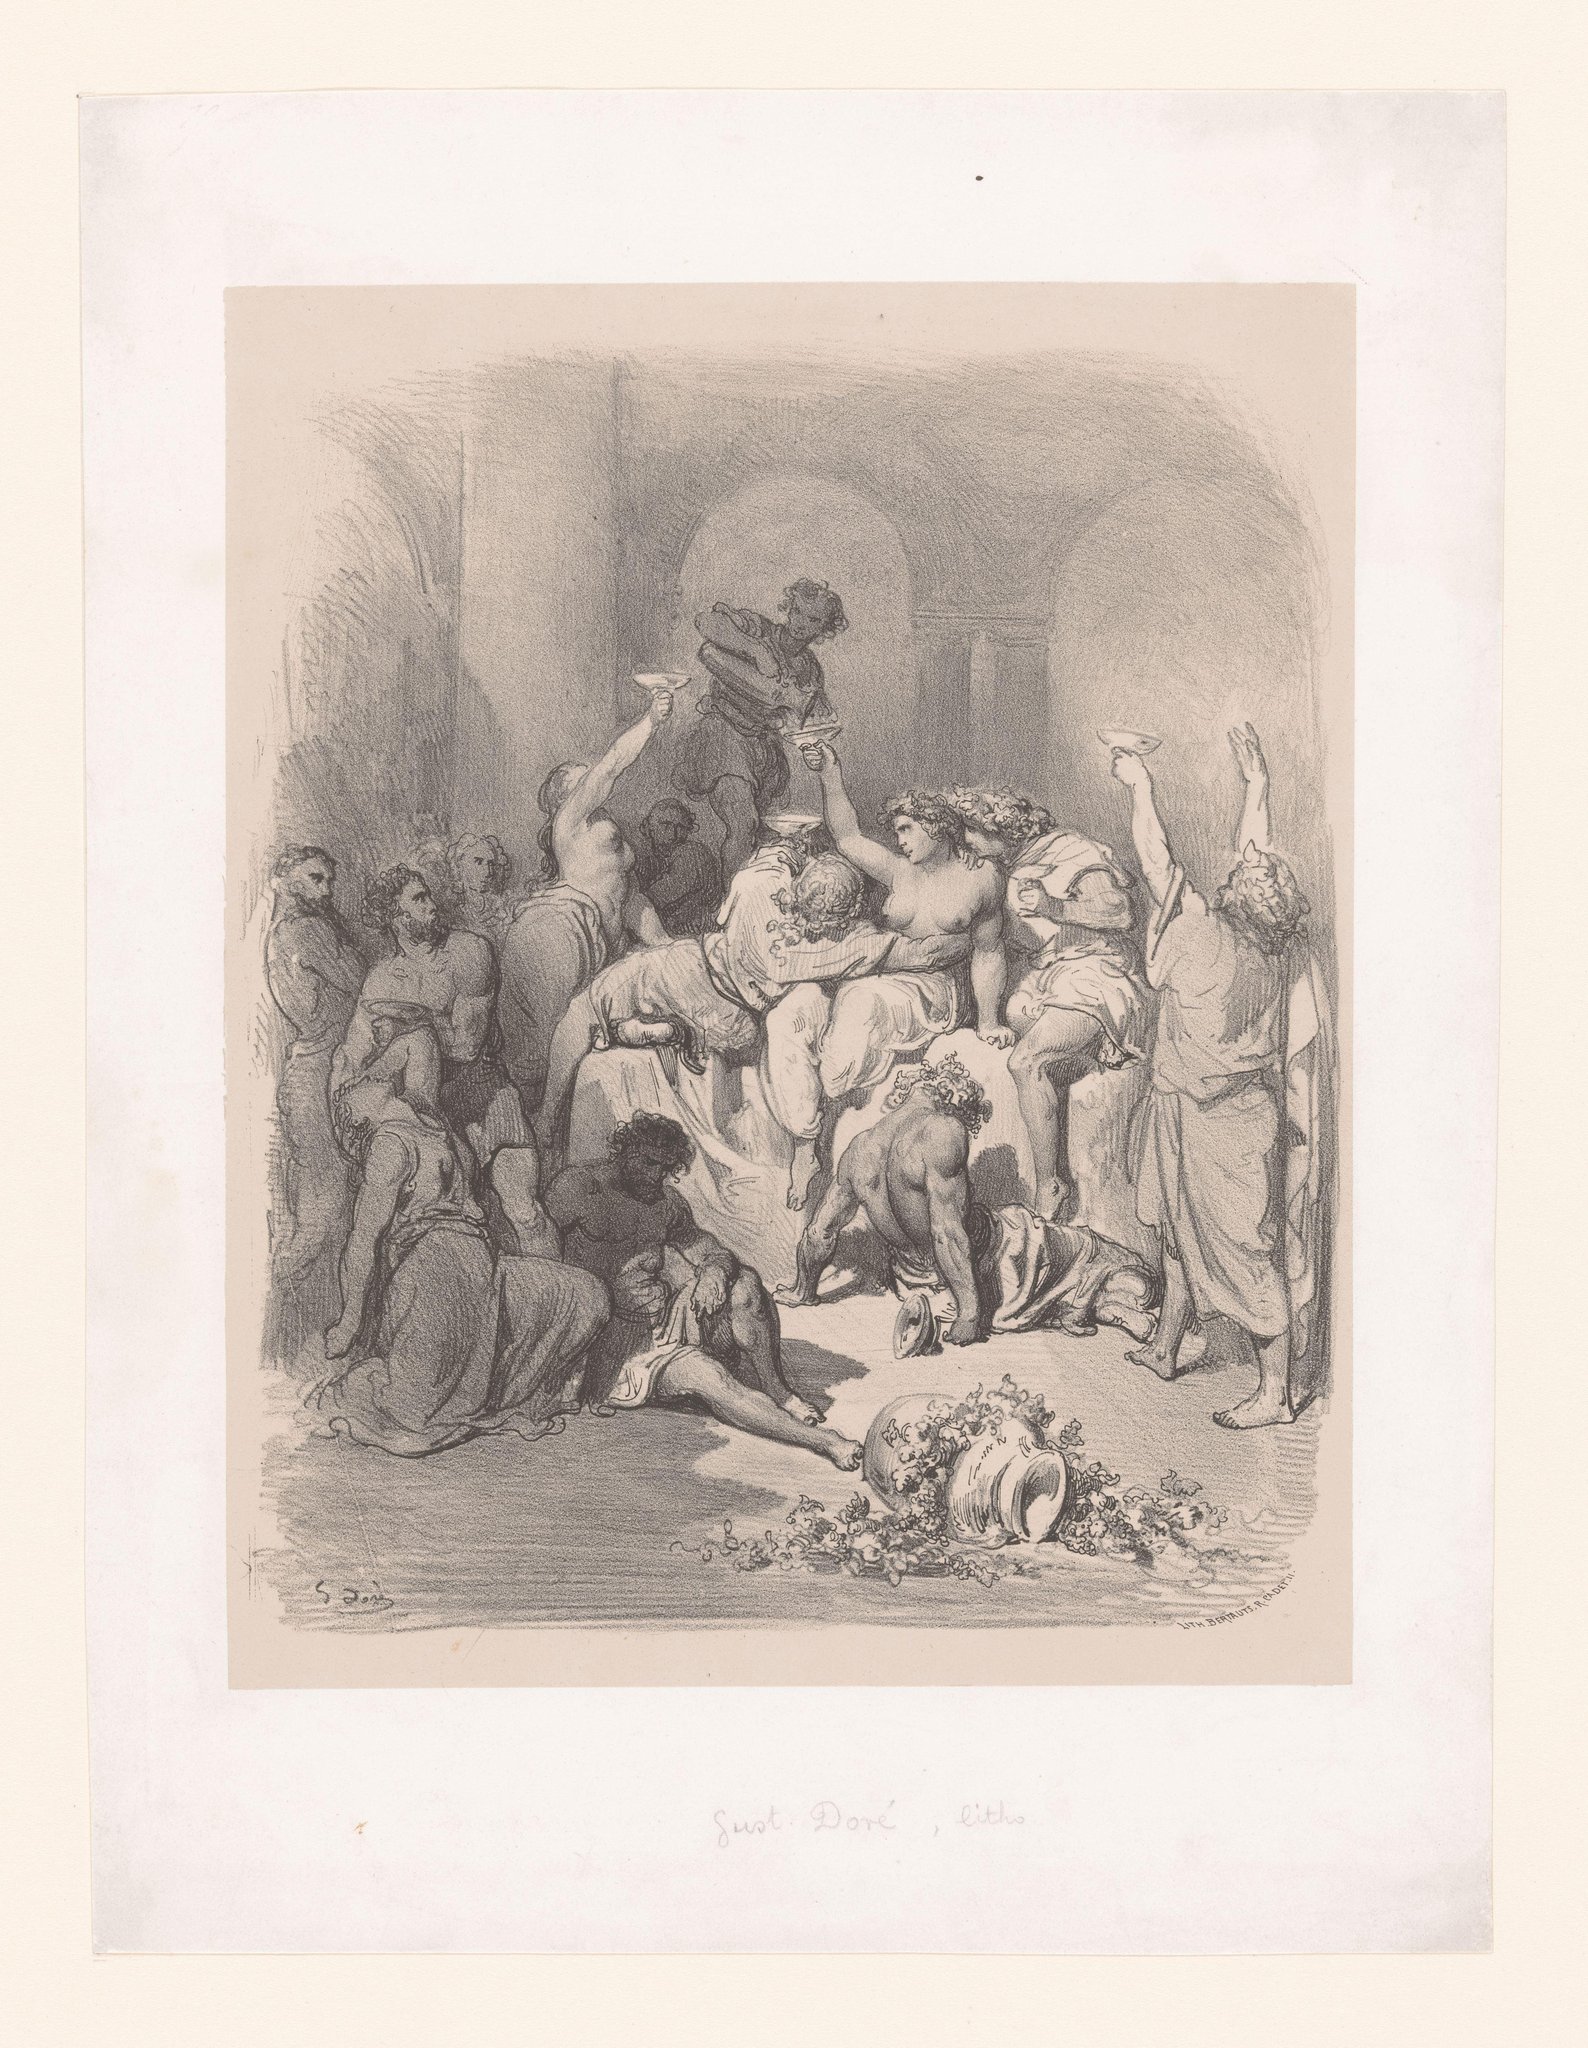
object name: print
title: Bacchanaal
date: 1845-1875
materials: paper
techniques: lithograph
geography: paris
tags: carousal, drinking-bout, orgy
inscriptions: collector's mark: Lugt 2228a